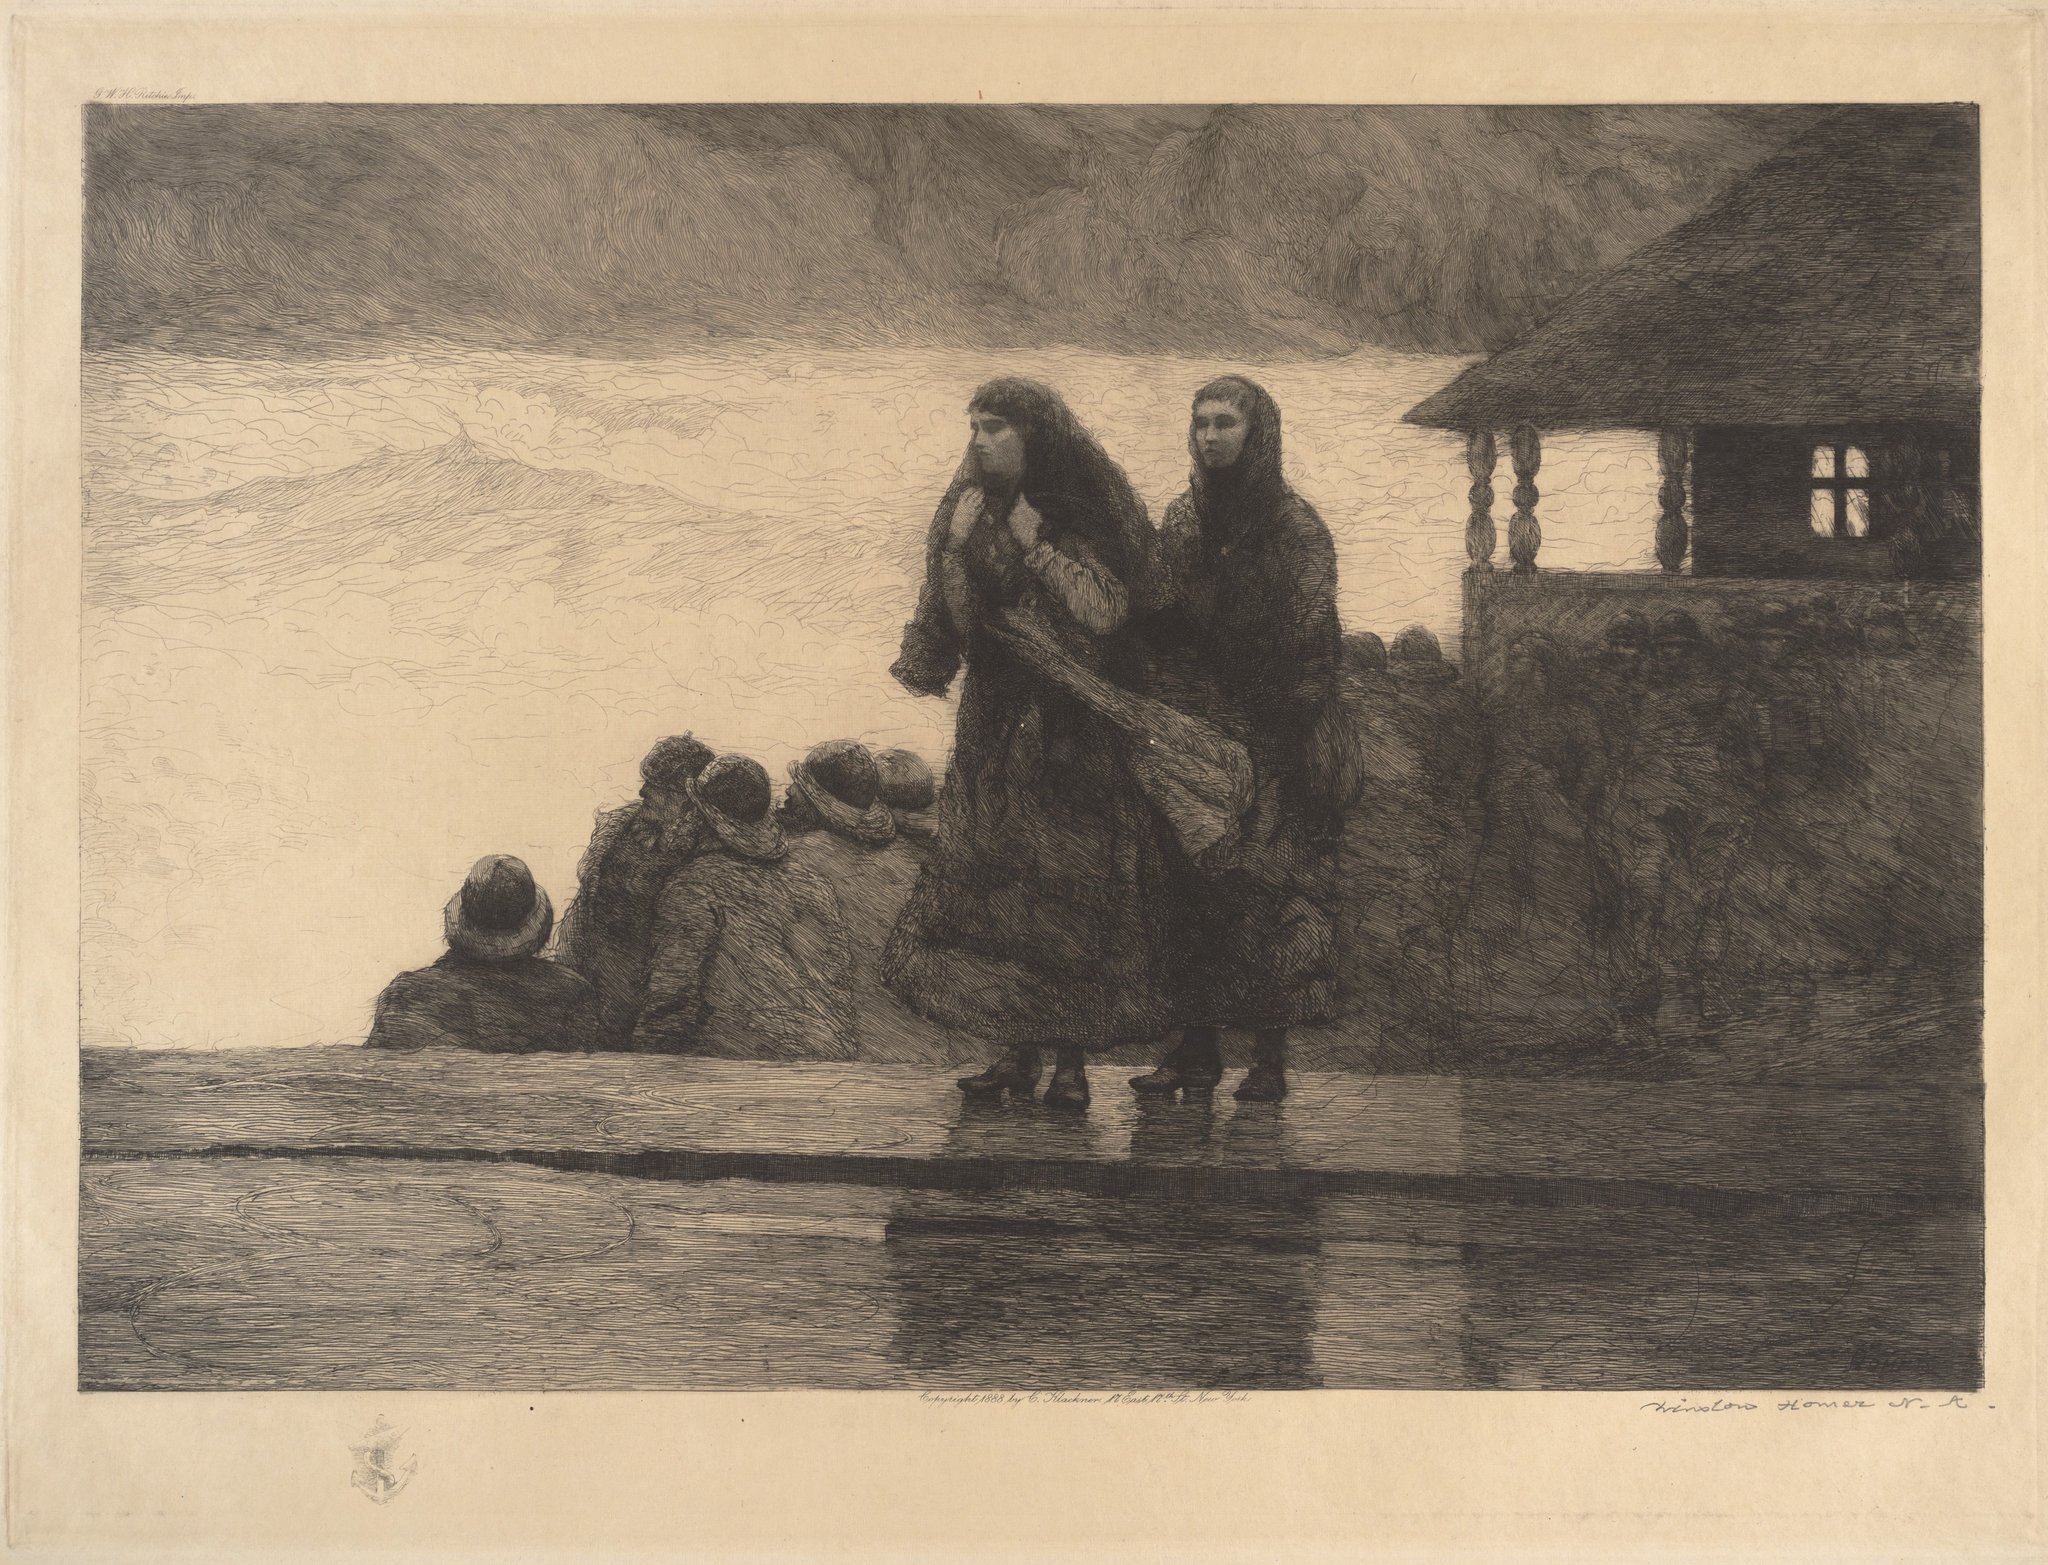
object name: print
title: Perils of the Sea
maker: winslow homer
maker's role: artist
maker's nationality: american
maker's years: 1836-1910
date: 1888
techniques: etching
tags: men,women,seas